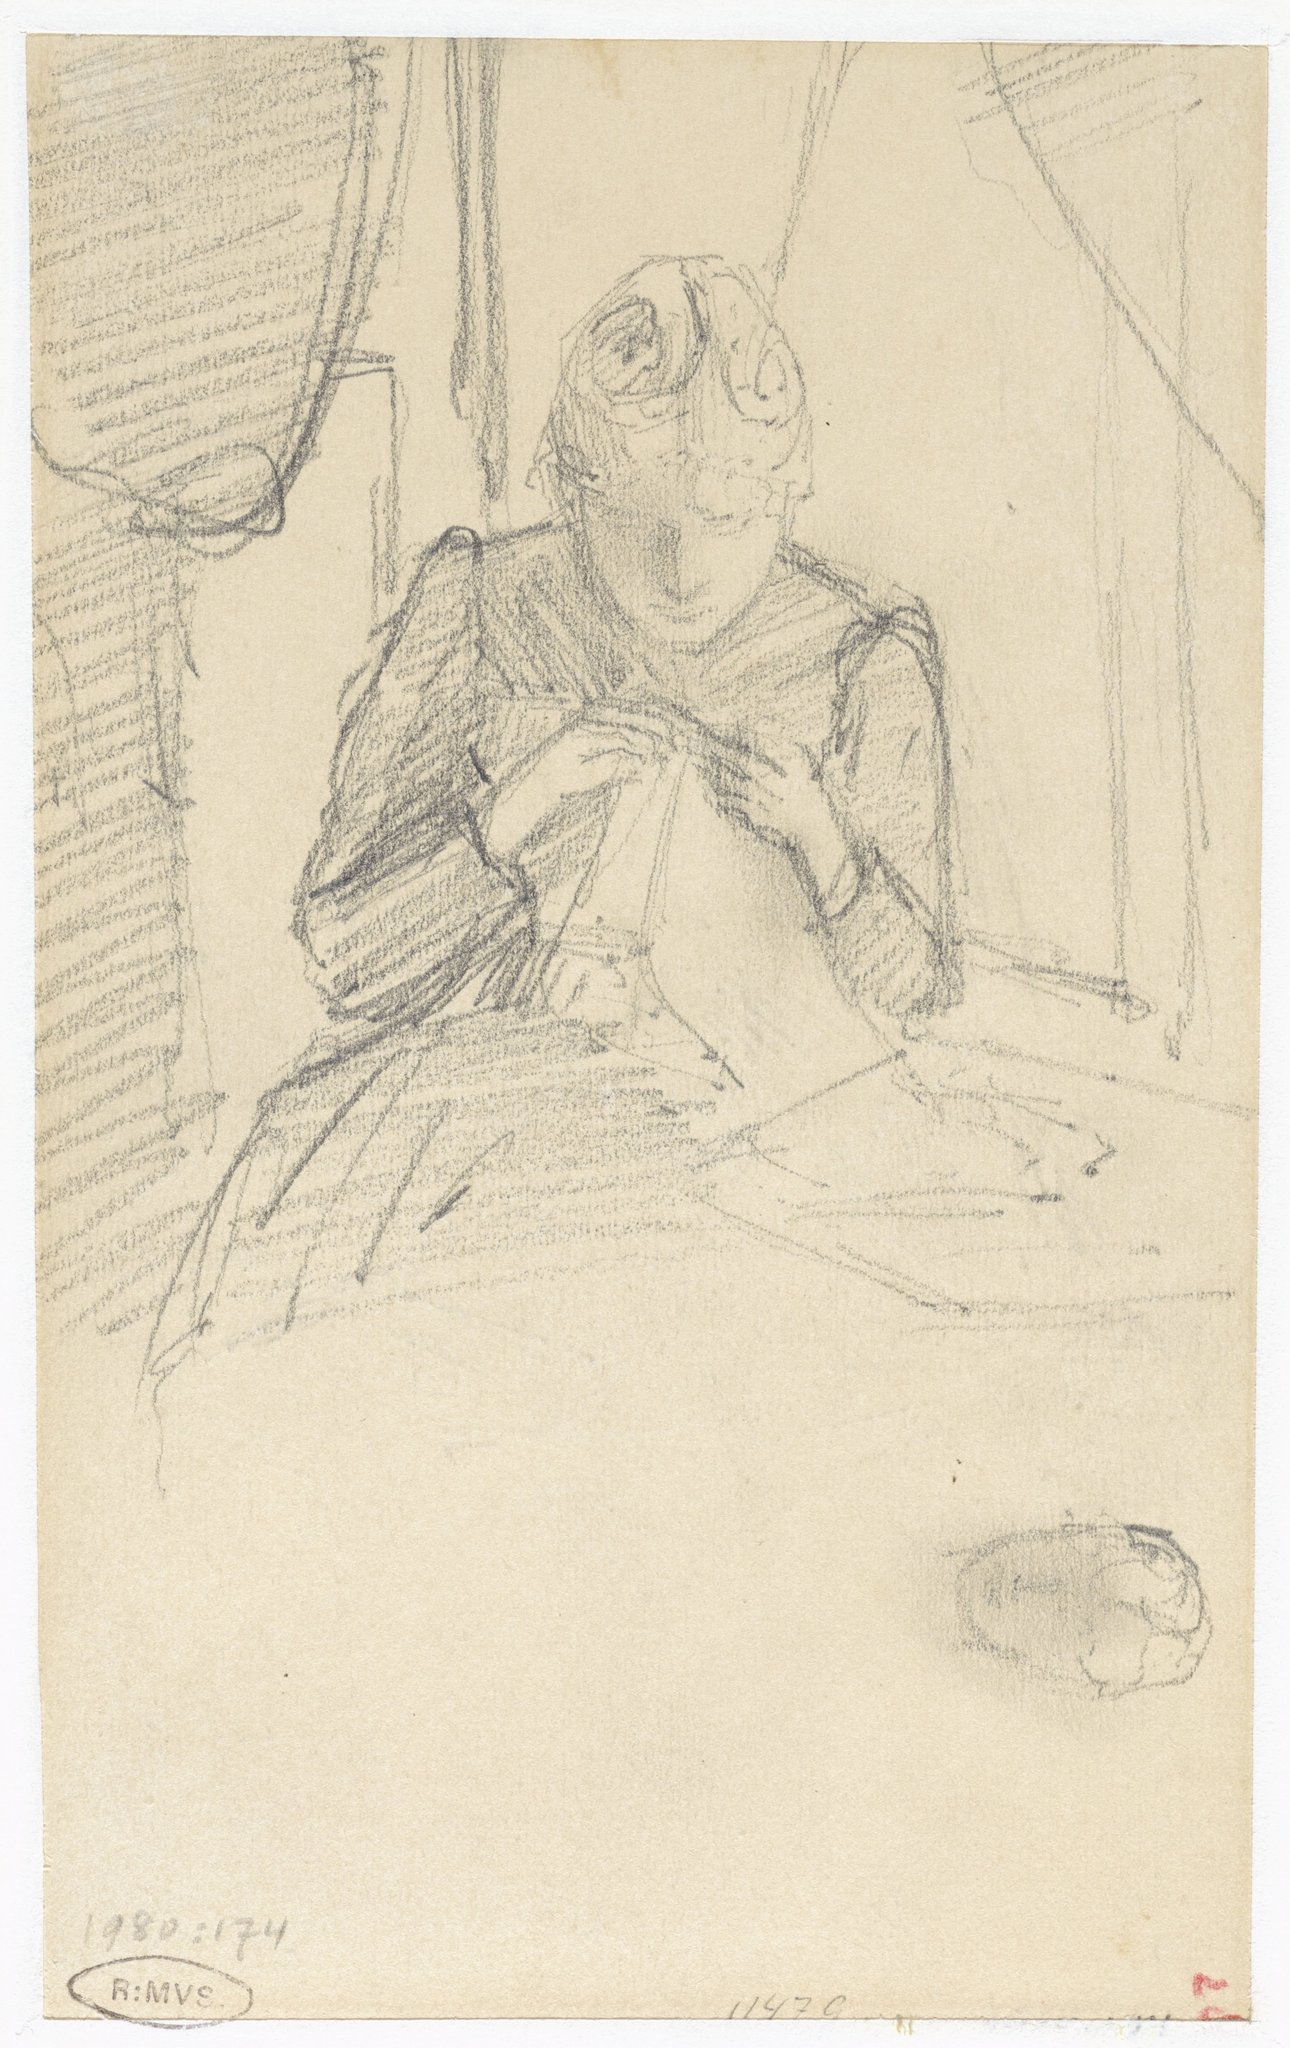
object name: drawing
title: Handwerkende vrouw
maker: jozef israëls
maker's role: draughtsman, painter, print maker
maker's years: 1824-1911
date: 1834-1911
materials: paper, pencil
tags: (other forms of) needlework, e.g.: crocheting, knitting, embroidering